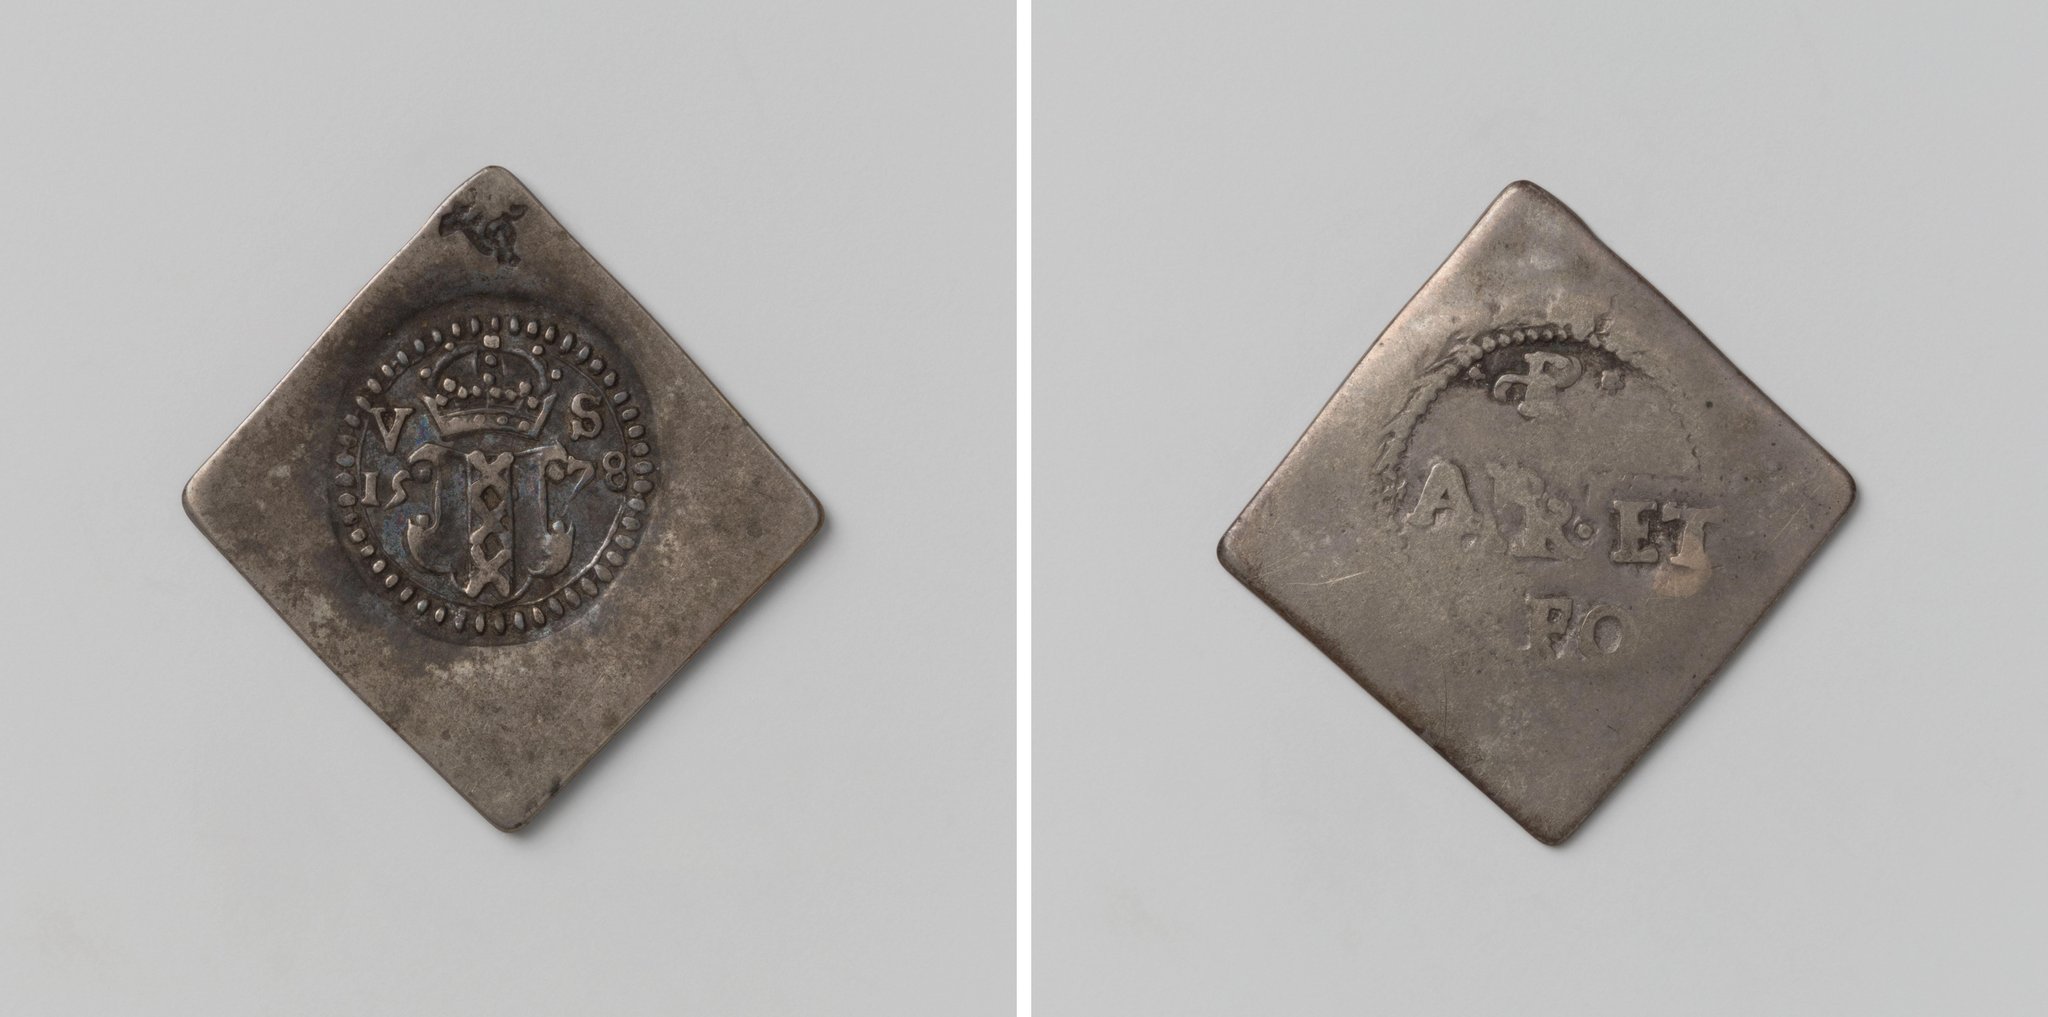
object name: siege coin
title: Vijf stuiver, noodmunt uit Amsterdam, geslagen tijdens het beleg uit het stedelijke zilver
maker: Anonymous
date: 1578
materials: silver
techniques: striking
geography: amsterdam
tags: amsterdam